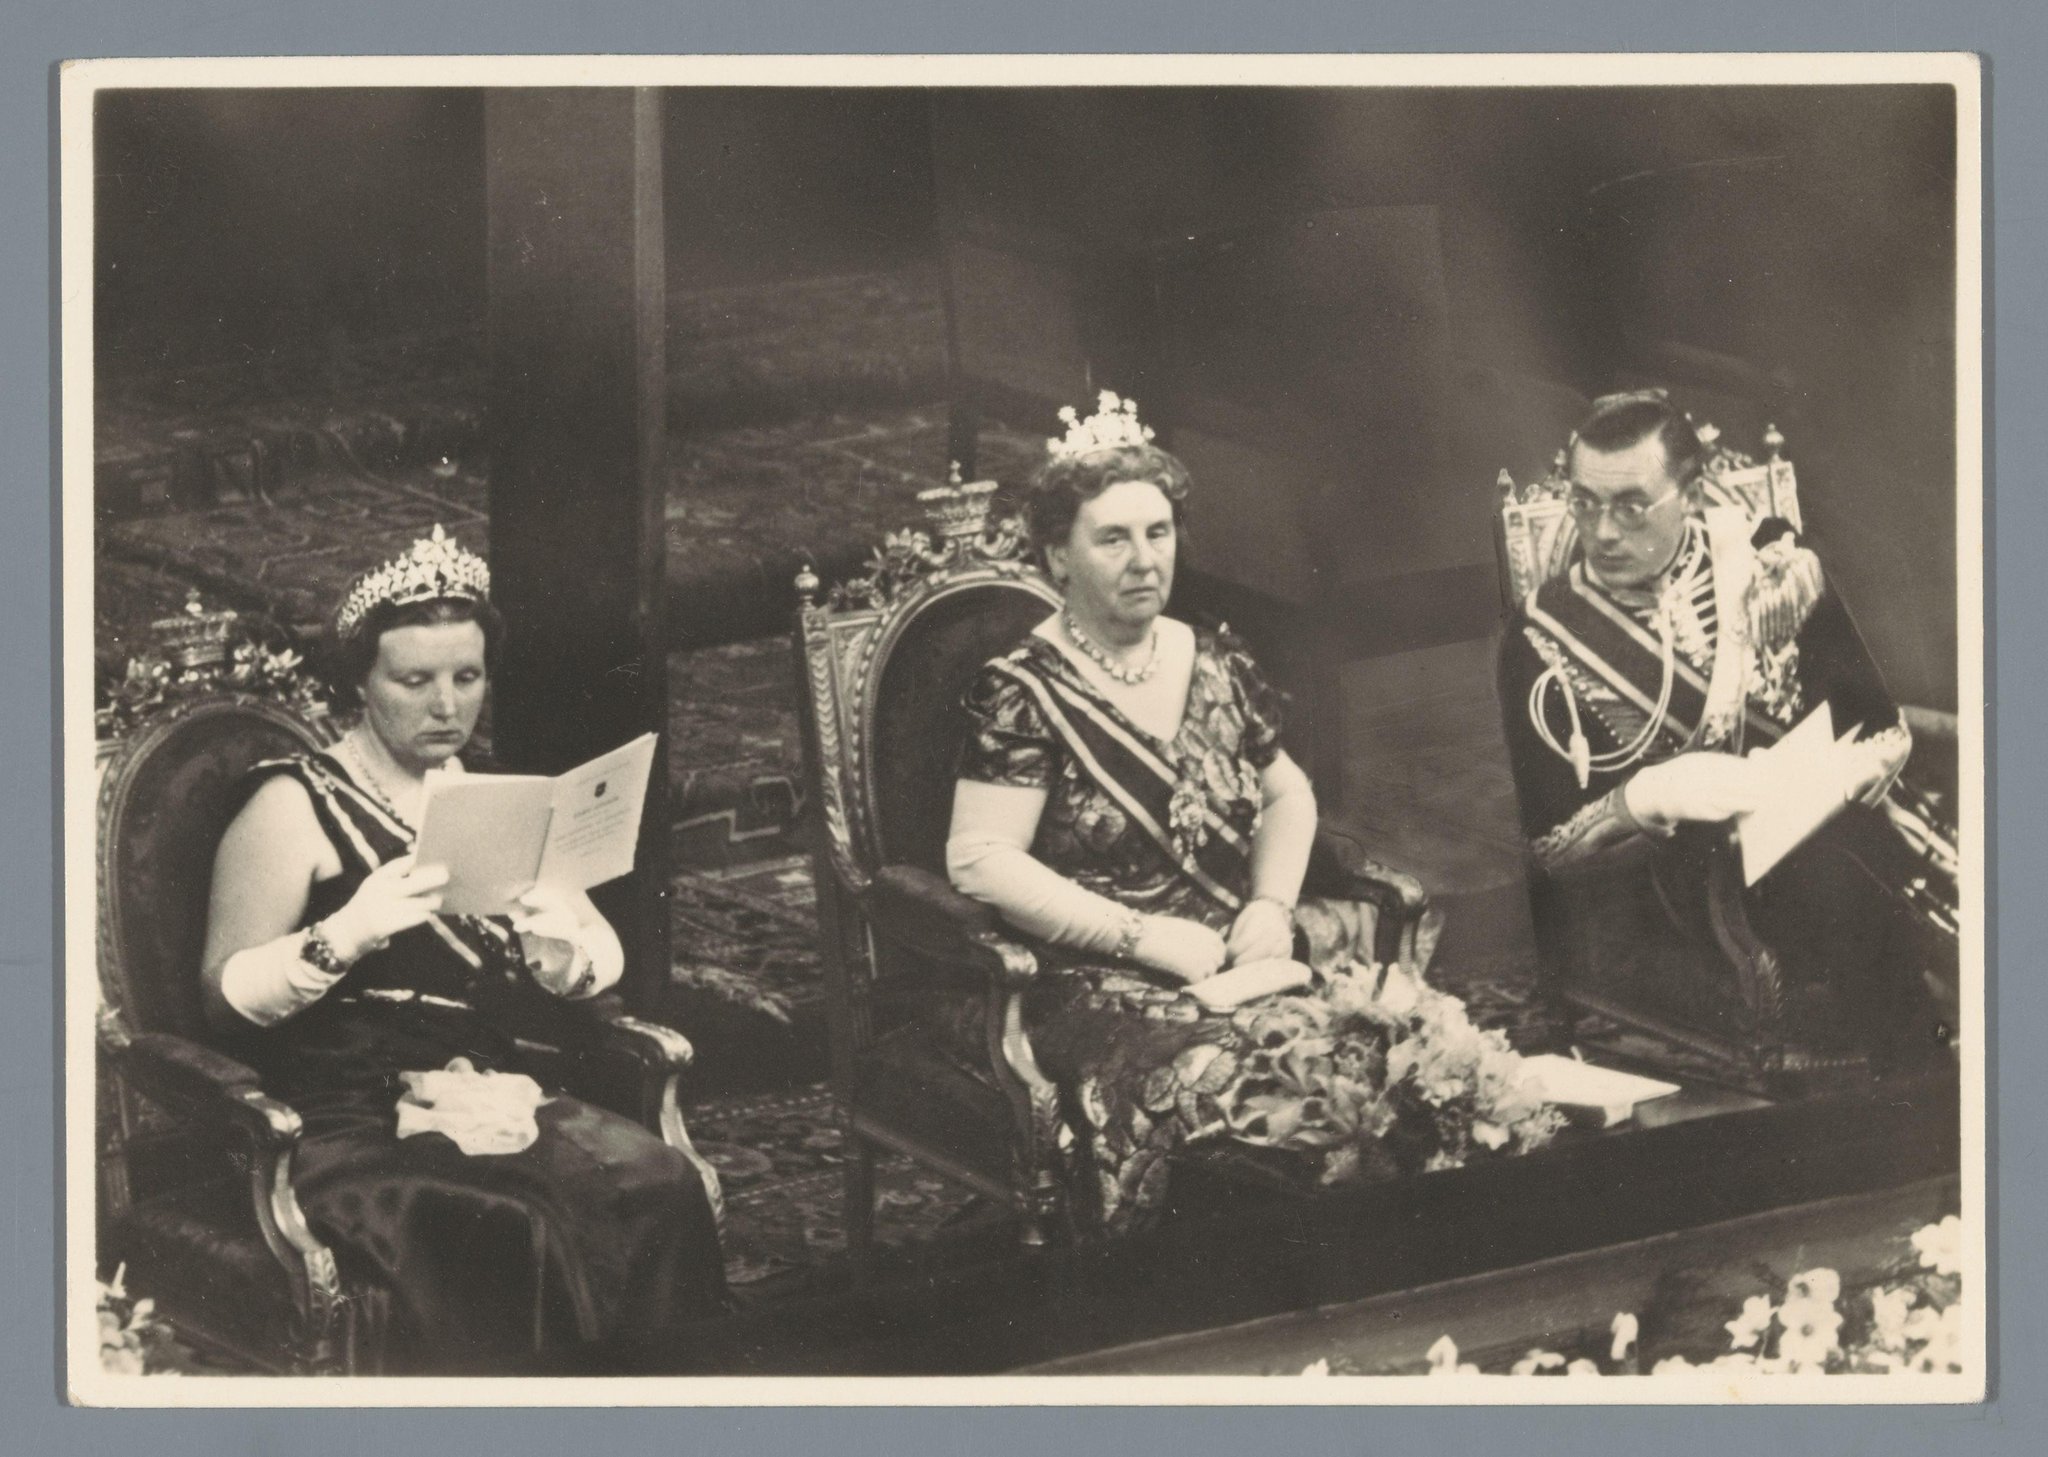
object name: photograph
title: Enkele dagen voor het 40- jarig regeerings jubileum van H.M. de koningin. Eereavond in het Gebouw voor Kunsten en Wetenschappen te 's Gravenhage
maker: Anonymous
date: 1938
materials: photographic support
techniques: gelatin silver print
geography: the hague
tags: wilhelmina of the netherlands, utrecht, bernhard (prins der nederlanden), juliana of the netherlands, crown princess, prince, queen